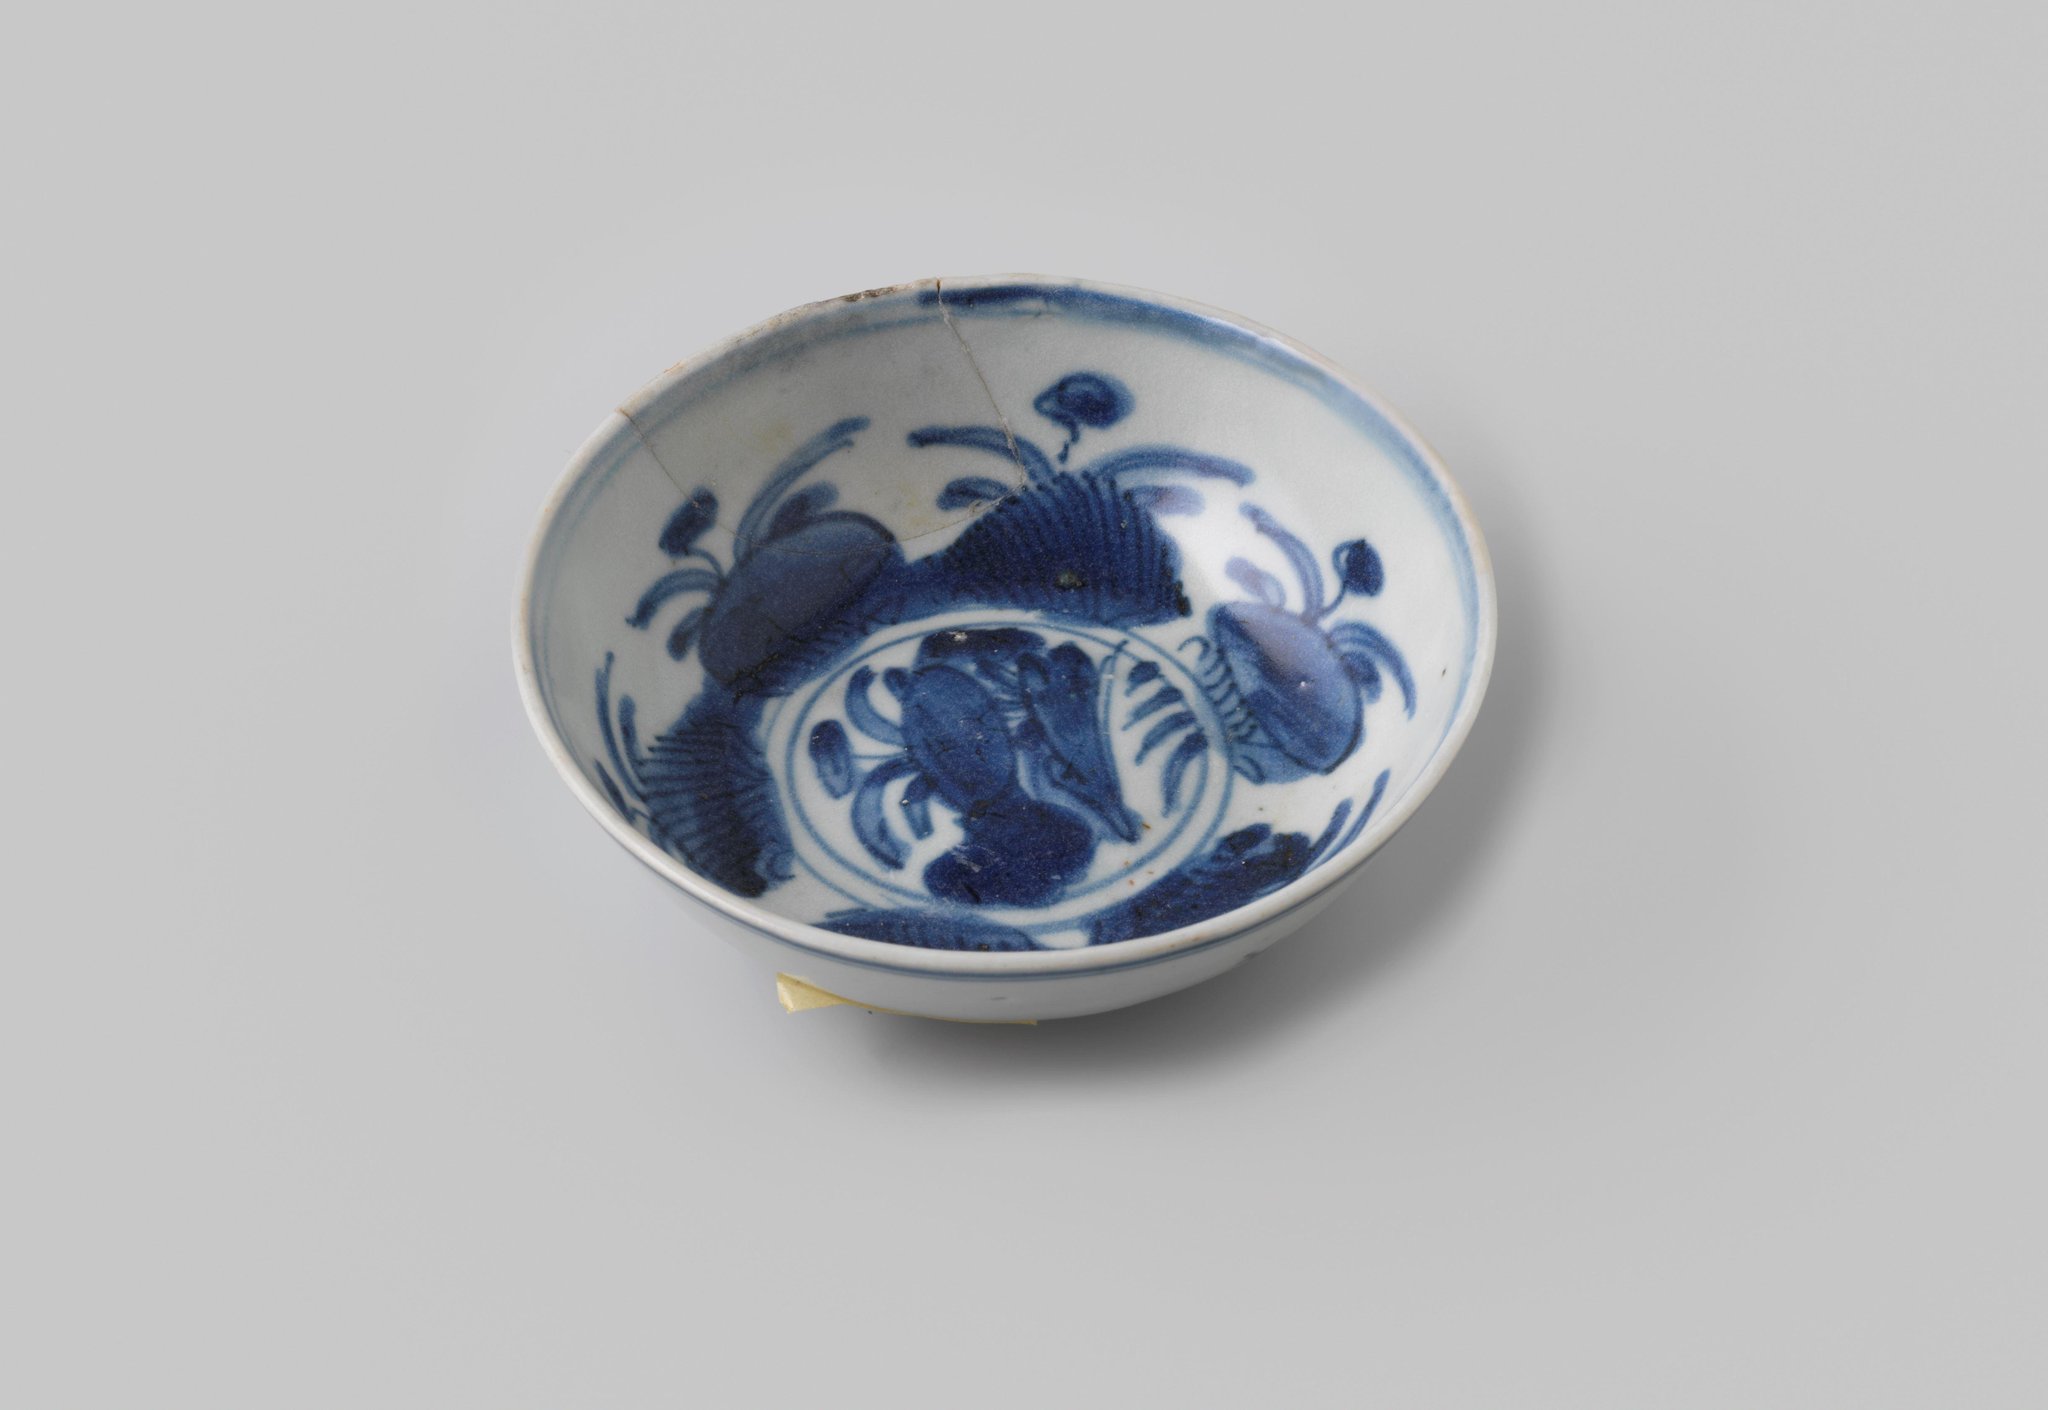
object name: platter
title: Schotel uit V.O.C.-schip de 'Witte Leeuw'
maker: Anonymous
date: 1613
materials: porcelain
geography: jingdezhen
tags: verenigde oostindische compagnie, sint-helena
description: A saucer. The decoration on the inside consists of a flowering lotus plant with a duck underneath in the centre. On the cavetto 6 similar lotus plants are drawn.